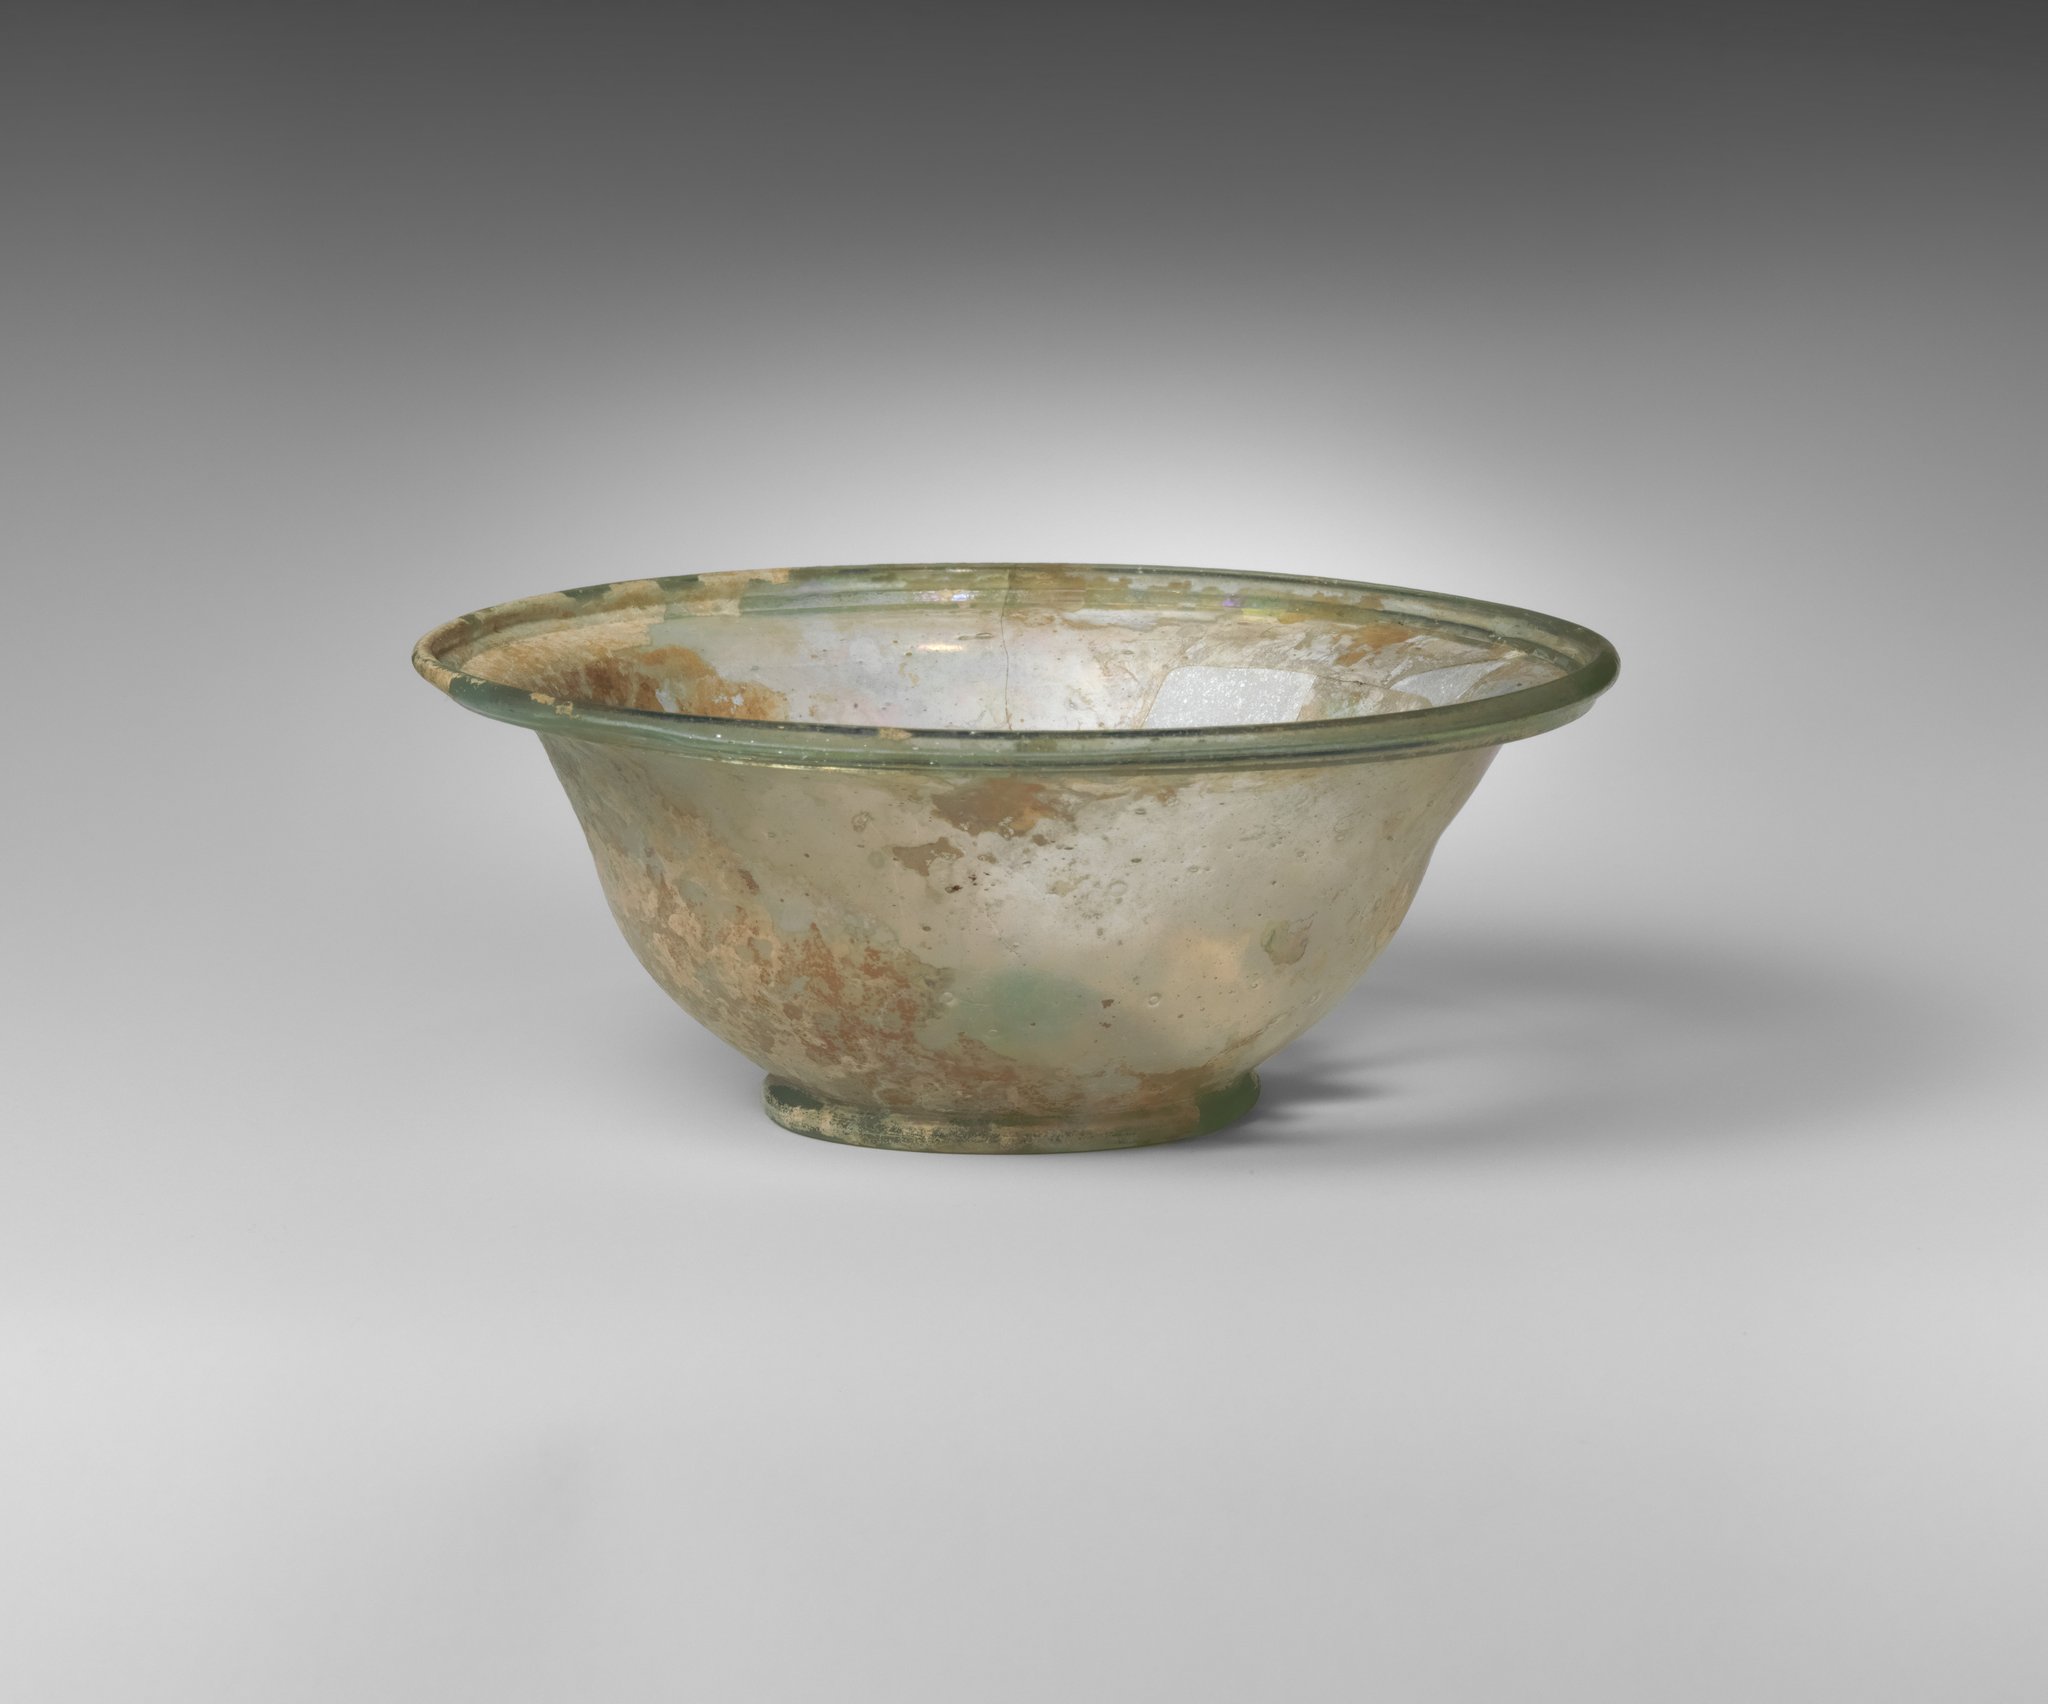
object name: bowl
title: Glass bowl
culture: roman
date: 101-300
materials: glass